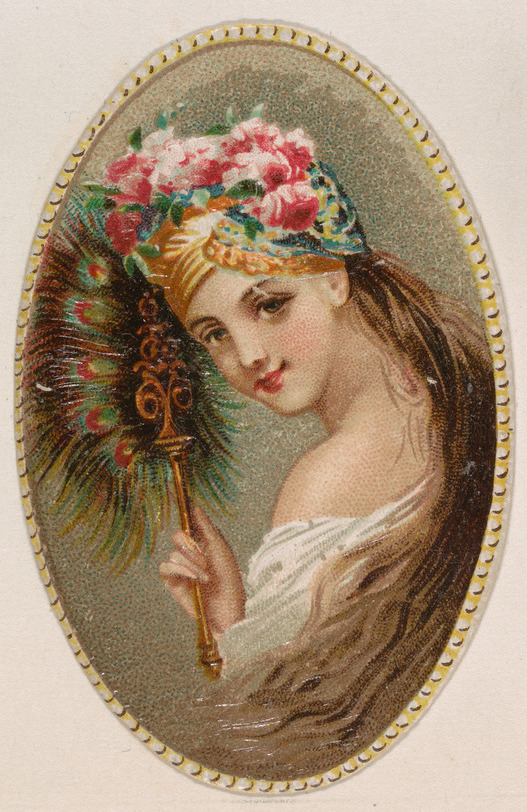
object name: print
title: Serving tray, from the Novelties series (N228, Type 4) issued by Kinney Bros.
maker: kinney brothers tobacco company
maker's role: publisher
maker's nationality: american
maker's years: 1869-2011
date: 1889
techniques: color lithograph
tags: women,trays